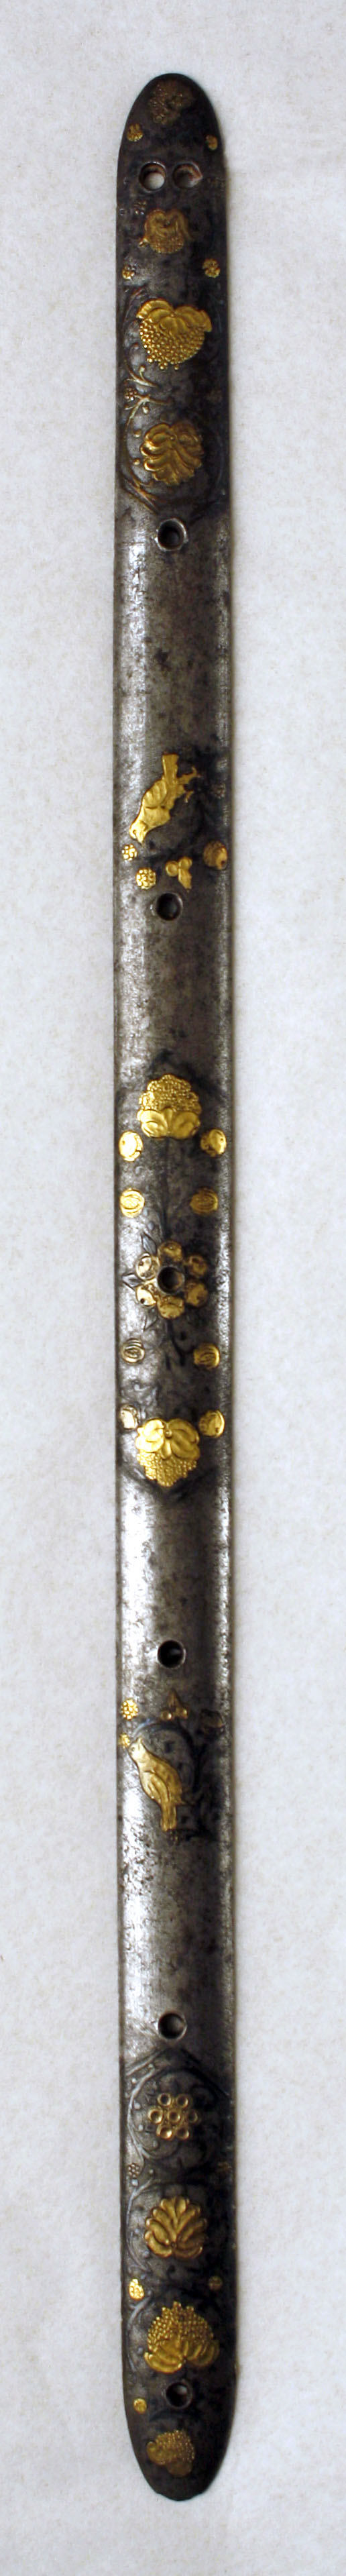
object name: busk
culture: french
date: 1601-1700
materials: metal